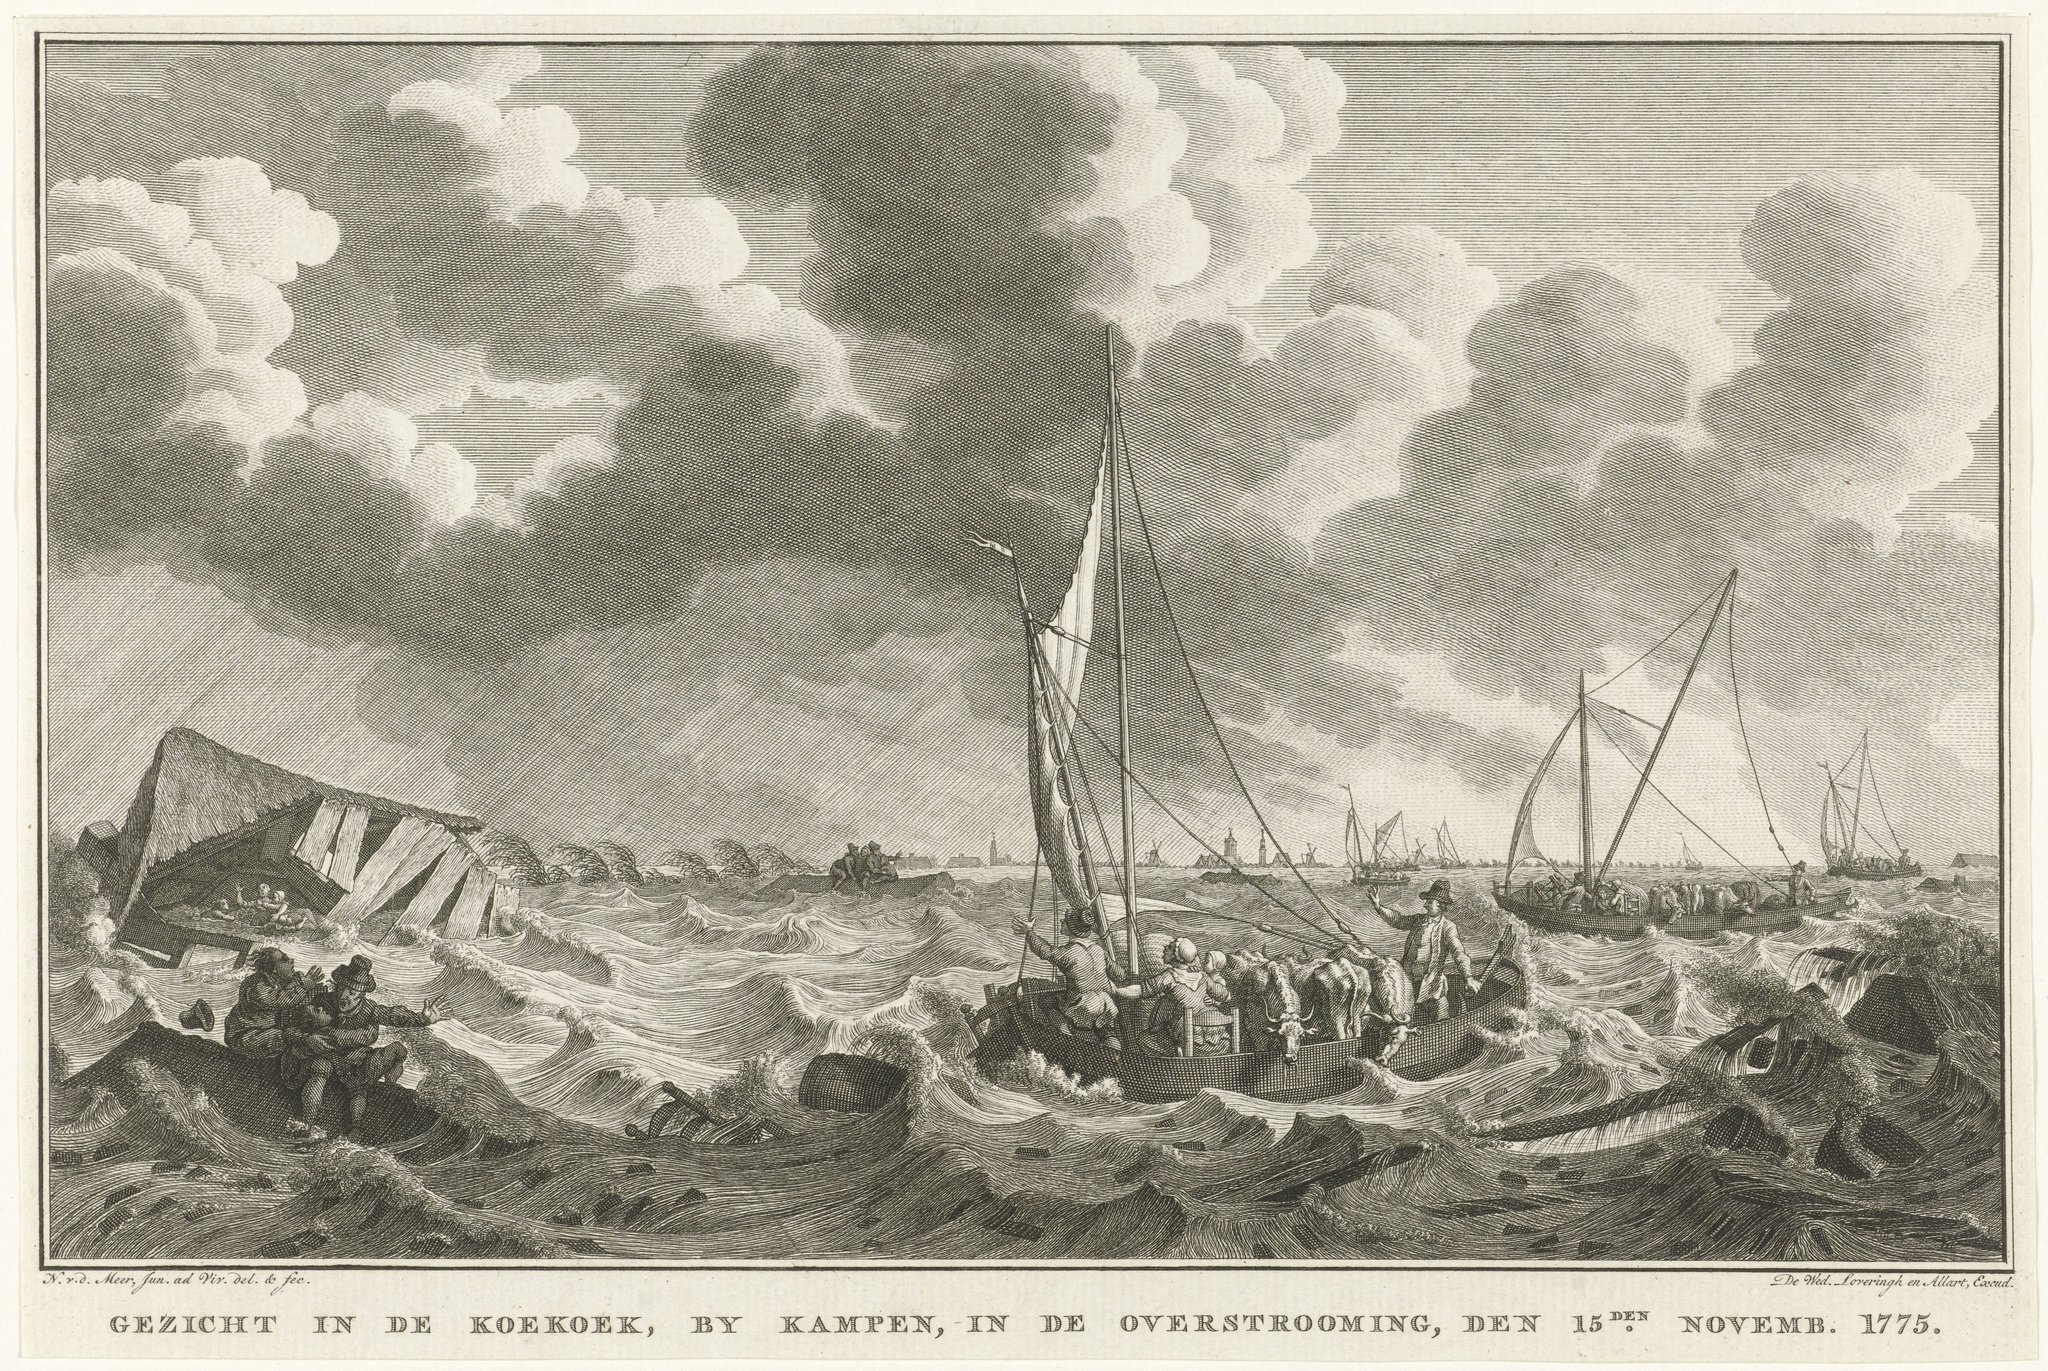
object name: print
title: Gezicht in de Koekoek, by Kampen, in de overstrooming, den 15den novemb. 1775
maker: noach van der meer (ii)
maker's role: draughtsman, print maker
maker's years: 1741-1822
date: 1775-1776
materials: paper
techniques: engraving, etching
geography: northern netherlands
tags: dike-break, the flood of 14-18 november 1775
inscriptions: collector's mark: Lugt 2228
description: Gebruikt als illustratie in: J.H. Hering, Bespiegeling over Neêrlandsch waternood, tusschen den 14den. en 15den. nov: MDCCLXXV. 2 dln. Amsterdam: wed. Loveringh en Allart, 1776.